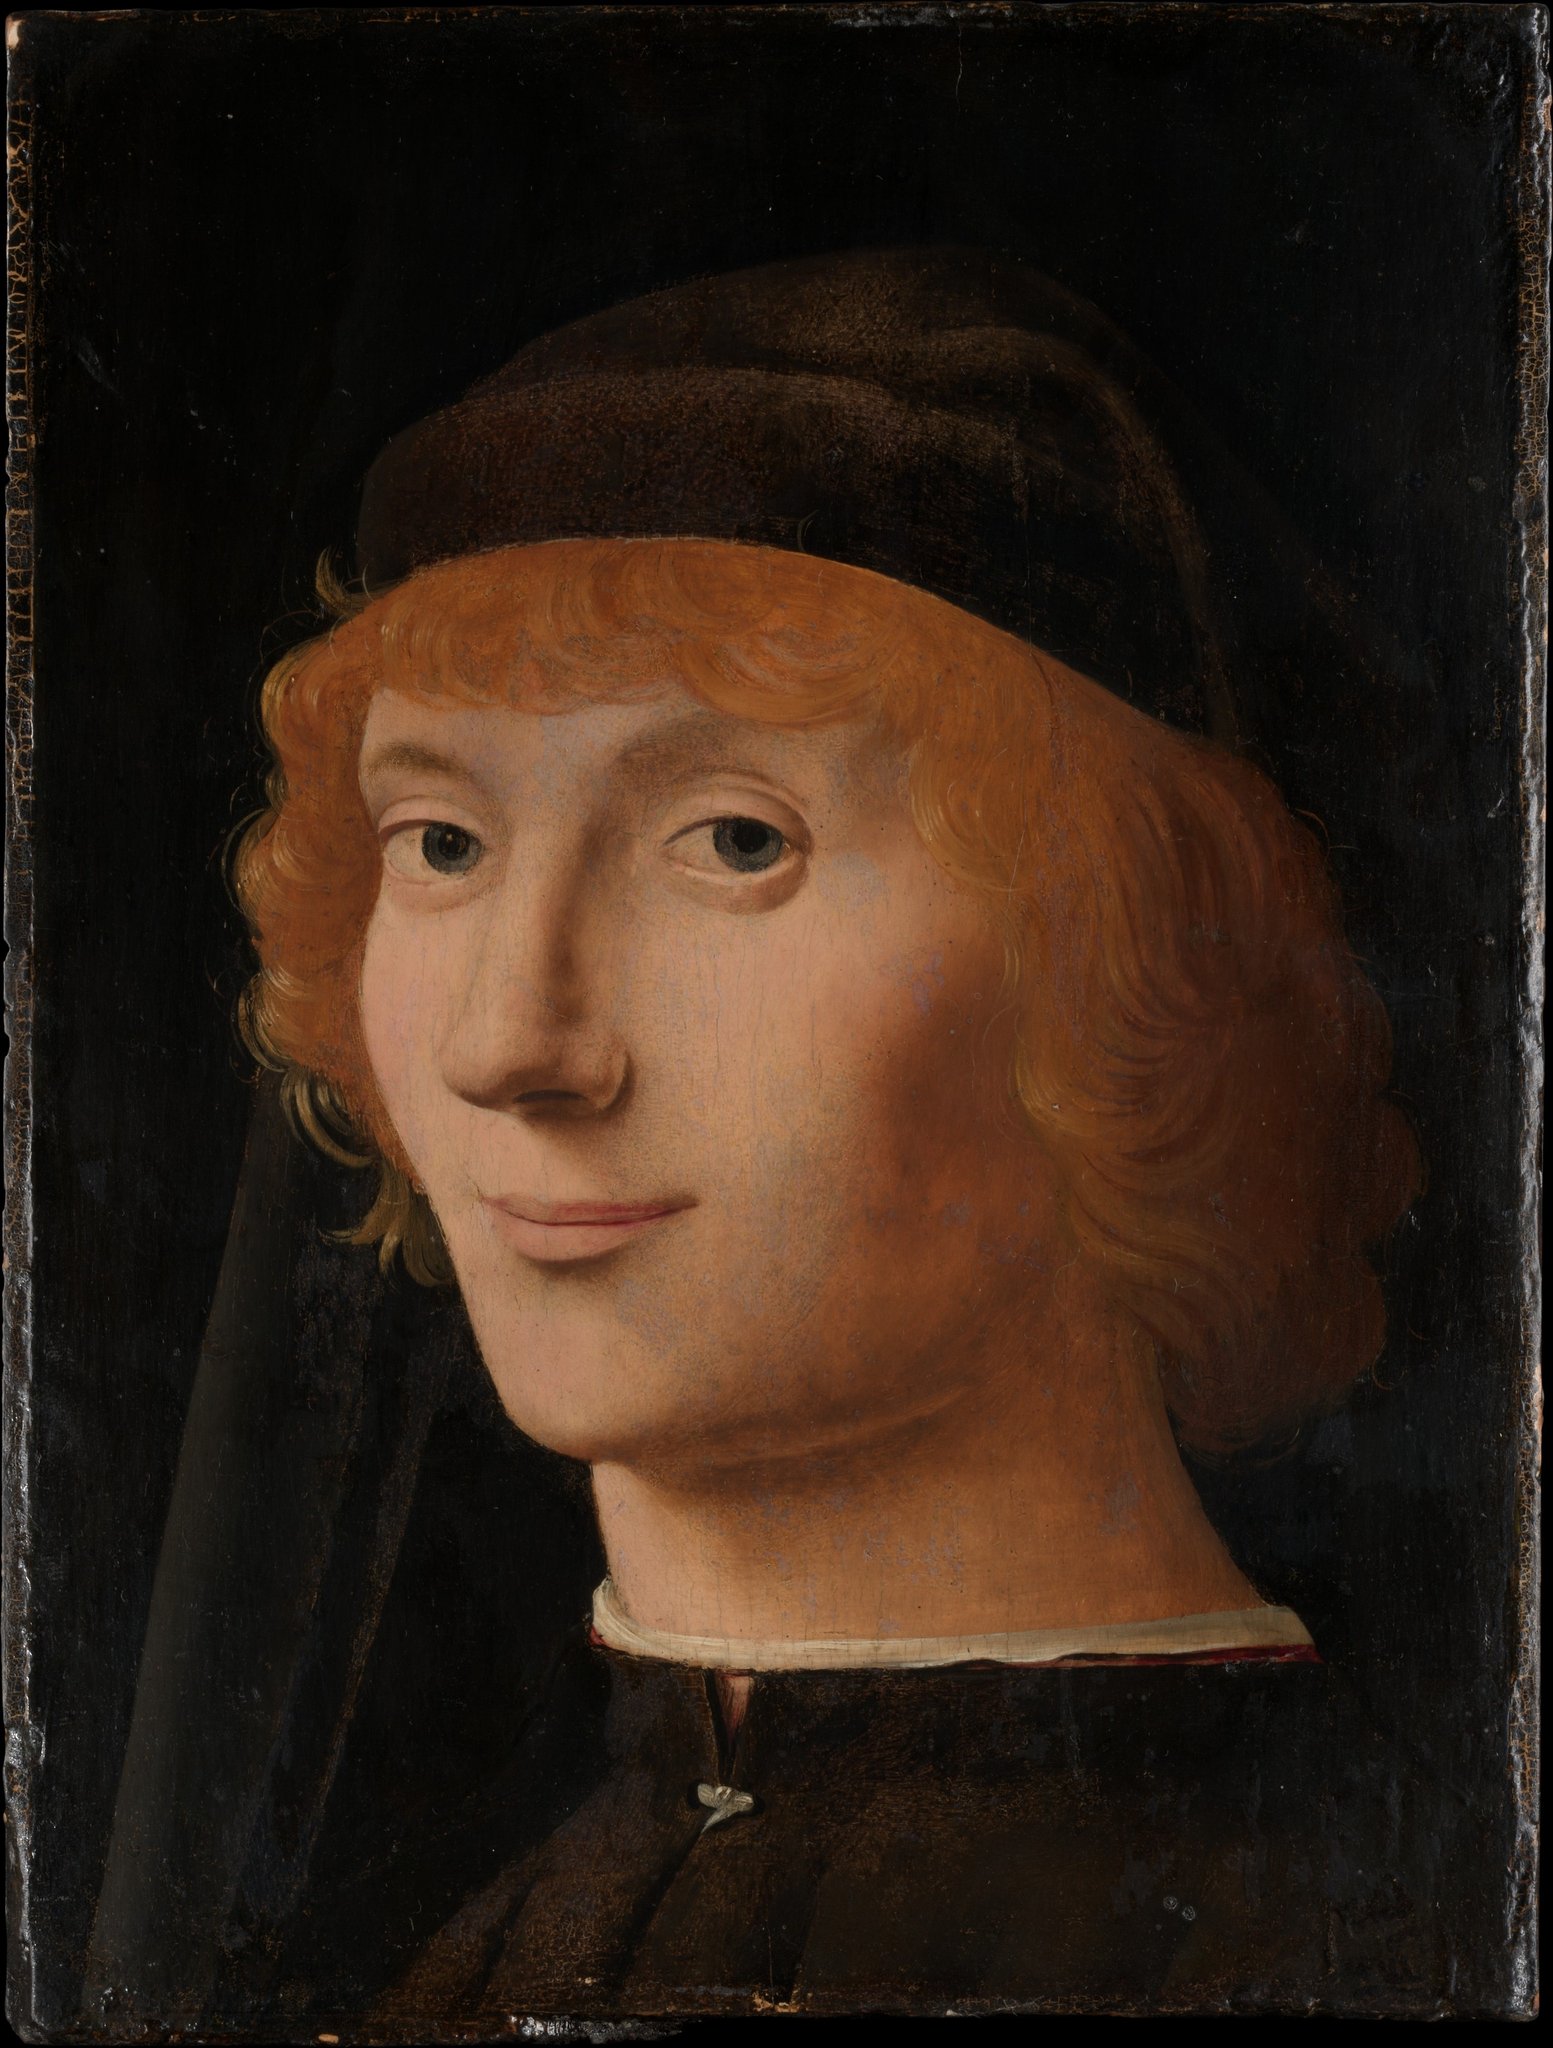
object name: painting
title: Portrait of a Young Man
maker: antonello da messina (antonello di giovanni d'antonio)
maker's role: artist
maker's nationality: italian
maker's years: 1430-1479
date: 1470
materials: oil, wood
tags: men,portraits